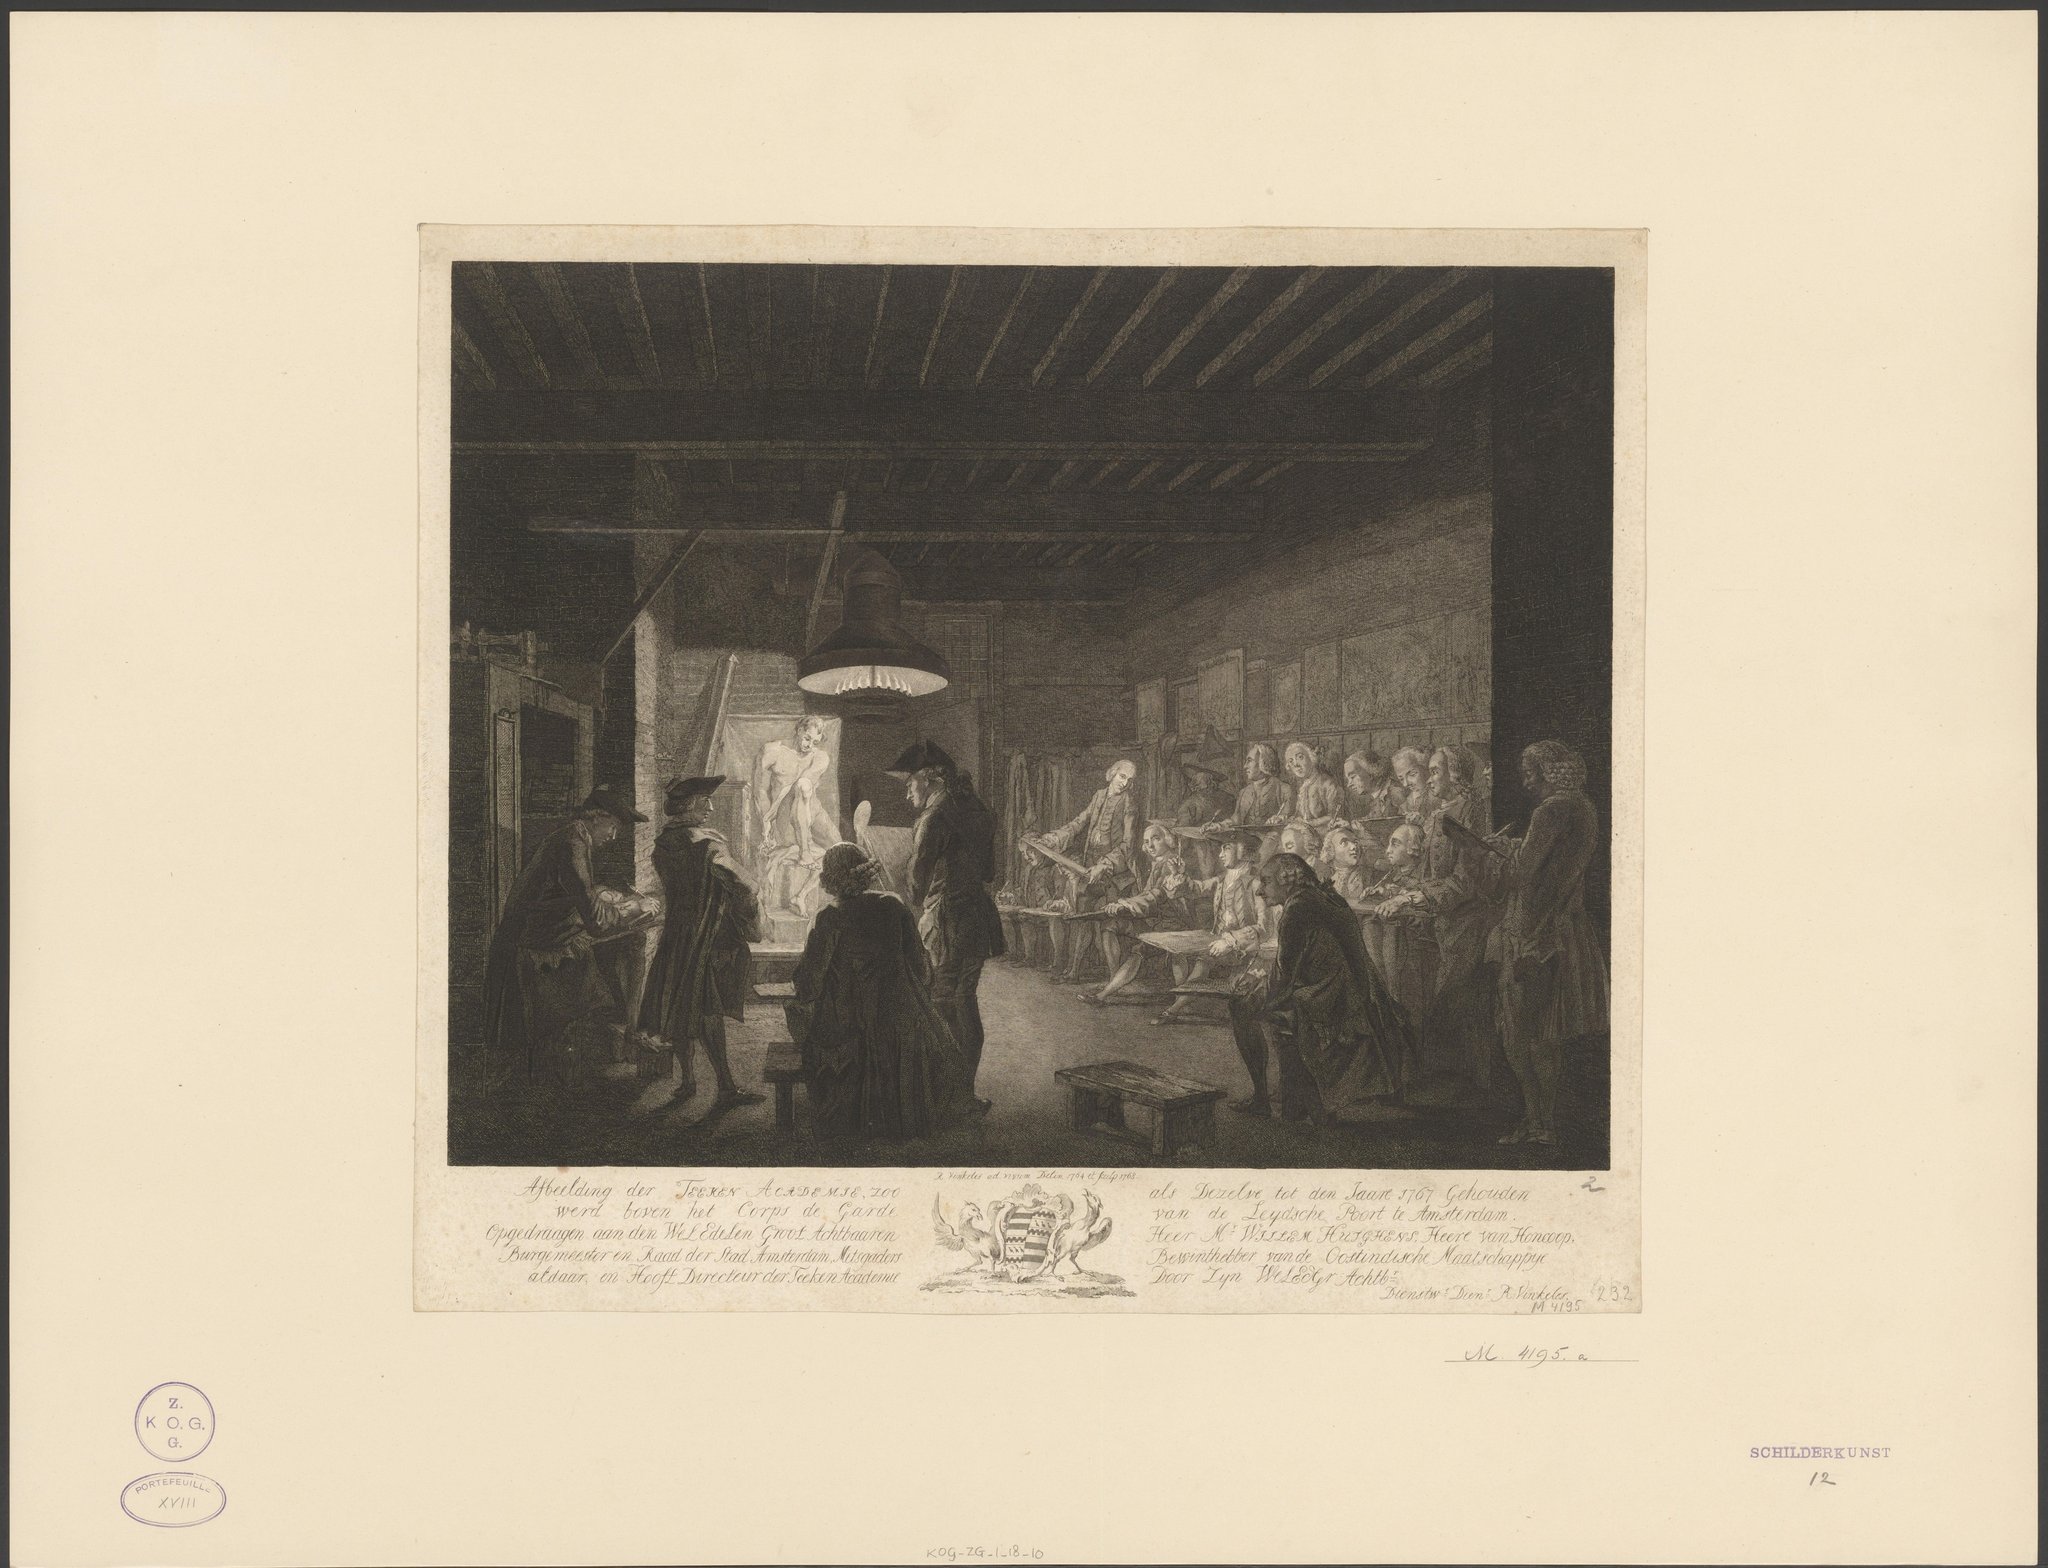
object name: print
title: Afbeelding der Teeken Academie, zoo als Dezelve tot den Jaare 1767 Gehouden werd boven het Corps de Garde van de Leydsche Poort te Amsterdam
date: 1768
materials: paper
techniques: engraving, etching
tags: tools, implements of draughtsman, place or institution of education and training of the artist, e.g.: academy of art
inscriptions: collector's mark: Lugt 1641, stamp, stamp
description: De stadstekenacademie (Teeken-Academie) boven het Corps de Garde in de Leidsepoort te Amsterdam in het jaar 1764. De tekenacademie verhuisde op 4 december 1767 naar het stadhuis op de Dam. Een groep mannelijke tekenleerlingen in een vrij donker interieur bij lamplicht tekenend naar een mannelijk naaktmodel, het model zittend van voren gezien. In de marge onderaan de titel en de opdracht aan Willem Huyghens met zijn familiewapen. Onderwerpsrubrieken binnen de Atlas Zeden en Gewoonten: Schoone kunsten, Schilderkunst, Ateliers.